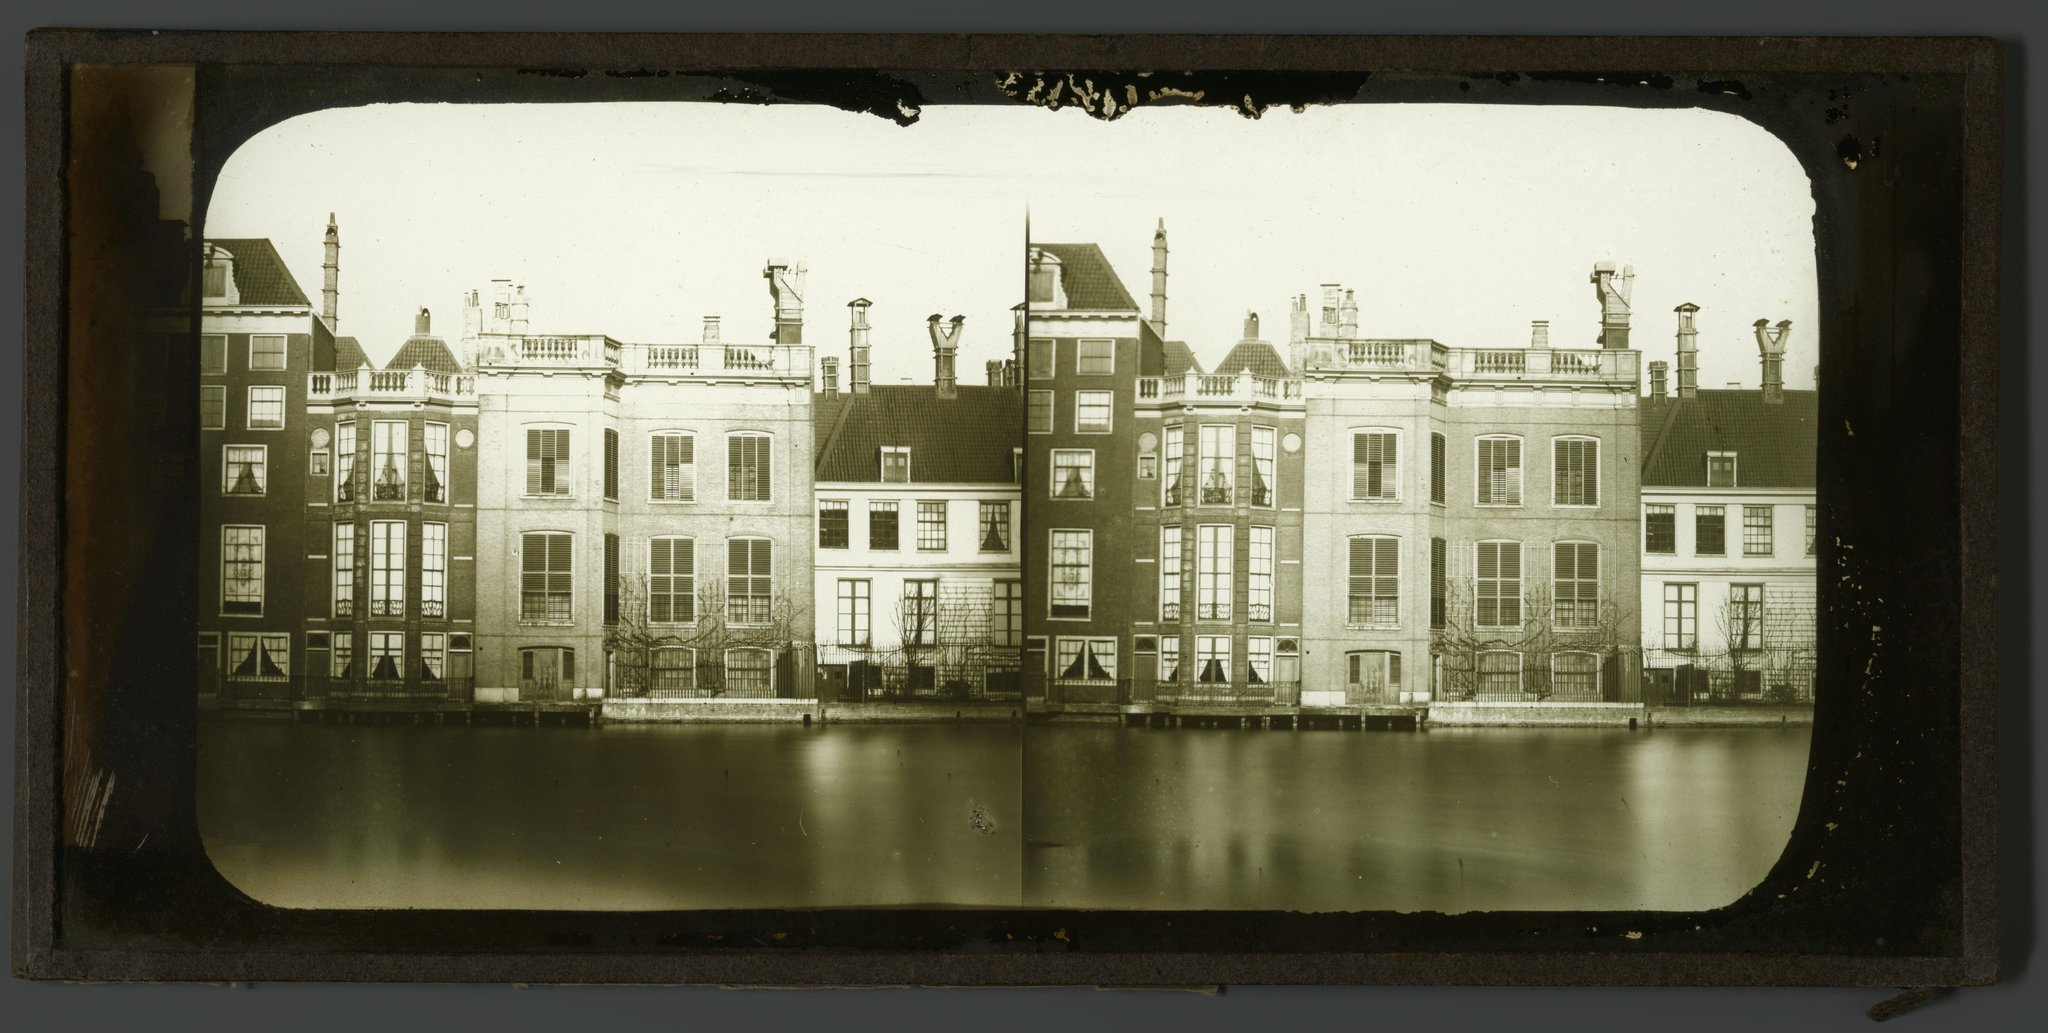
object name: photograph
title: Gezicht op de Amstel en de achterzijde van de Oude Doelenstraat, Amsterdam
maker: pieter oosterhuis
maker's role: draughtsman, print maker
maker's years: 1816-1885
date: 1860-1885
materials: glass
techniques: slide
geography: amsterdam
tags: urban housing